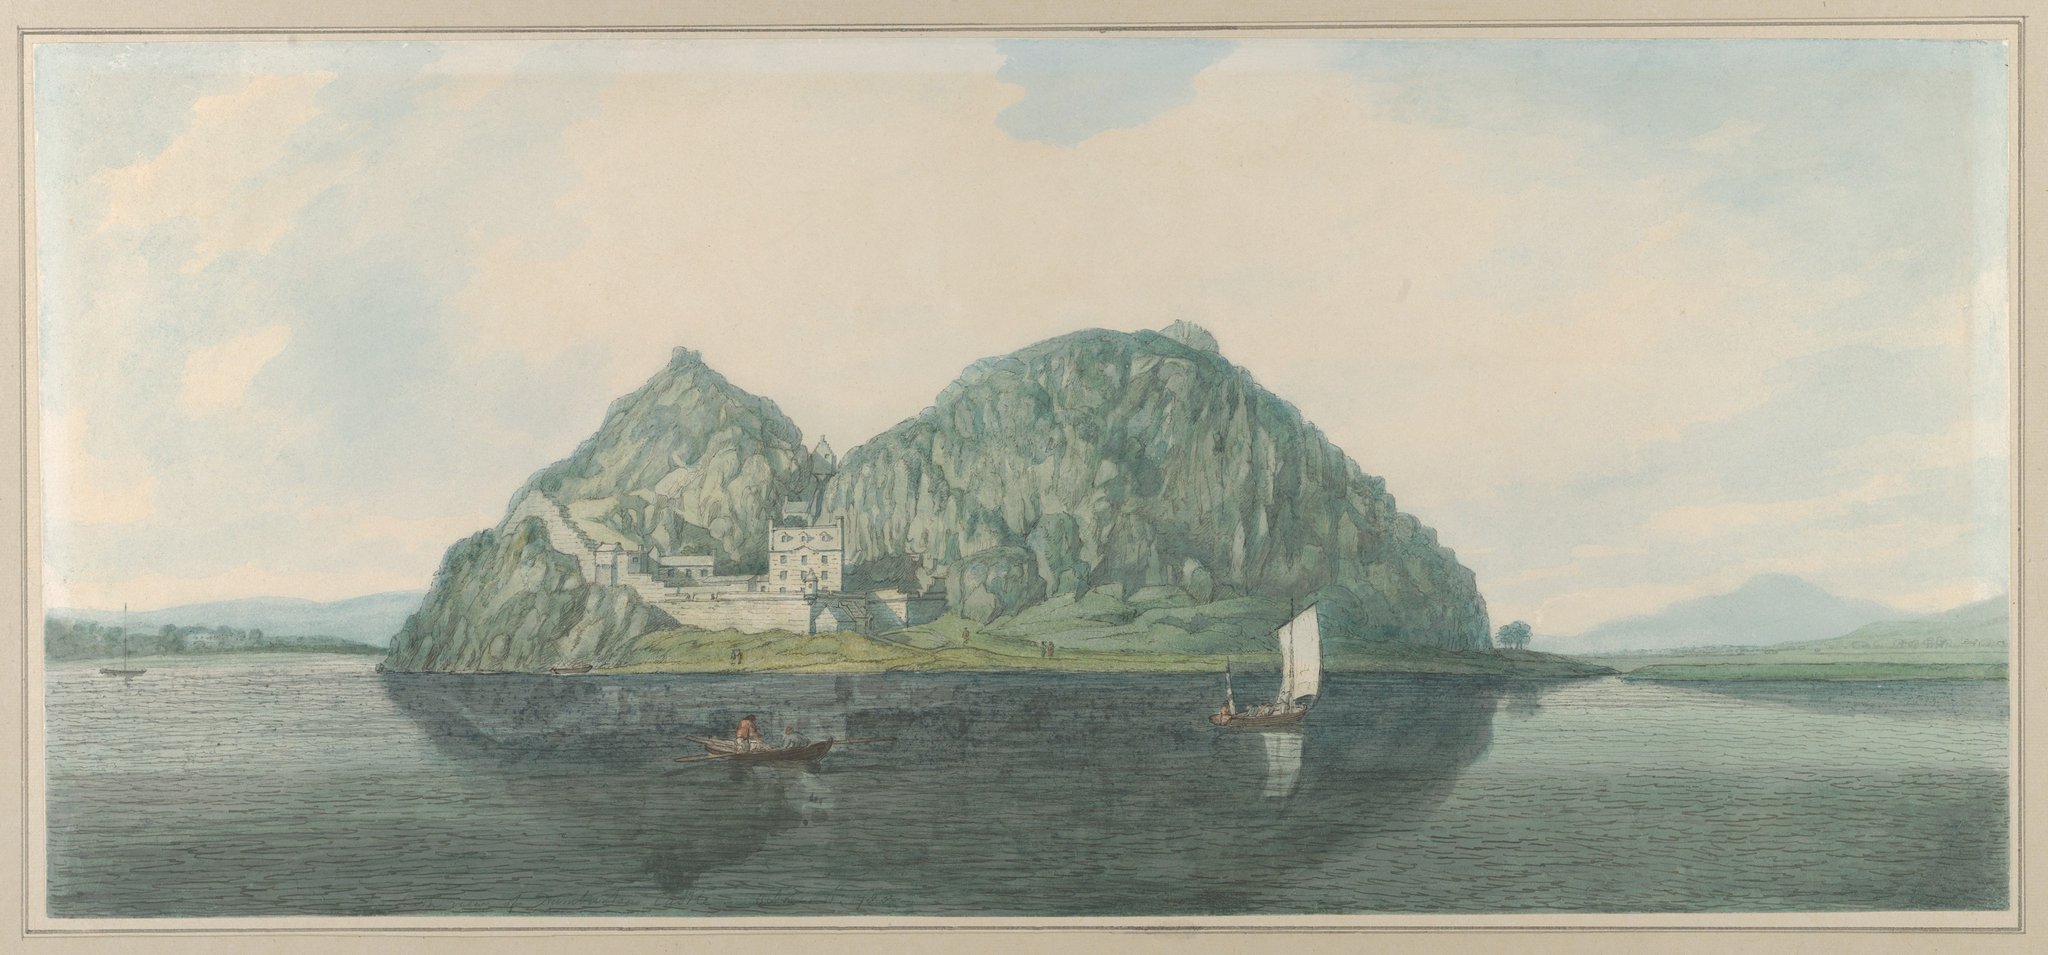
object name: drawing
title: Dumbarton Rock from the South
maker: joseph farington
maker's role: artist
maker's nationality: british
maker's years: 1747-1821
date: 1788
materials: ink, watercolor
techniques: pen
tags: houses,landscapes,boats